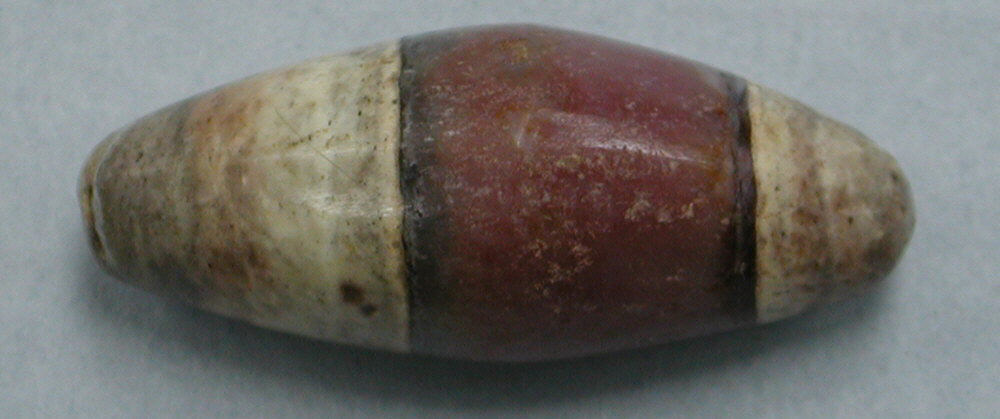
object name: ritual stone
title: Polishing Stone (pulidor)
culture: mexican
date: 1501-1600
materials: stone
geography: mexico